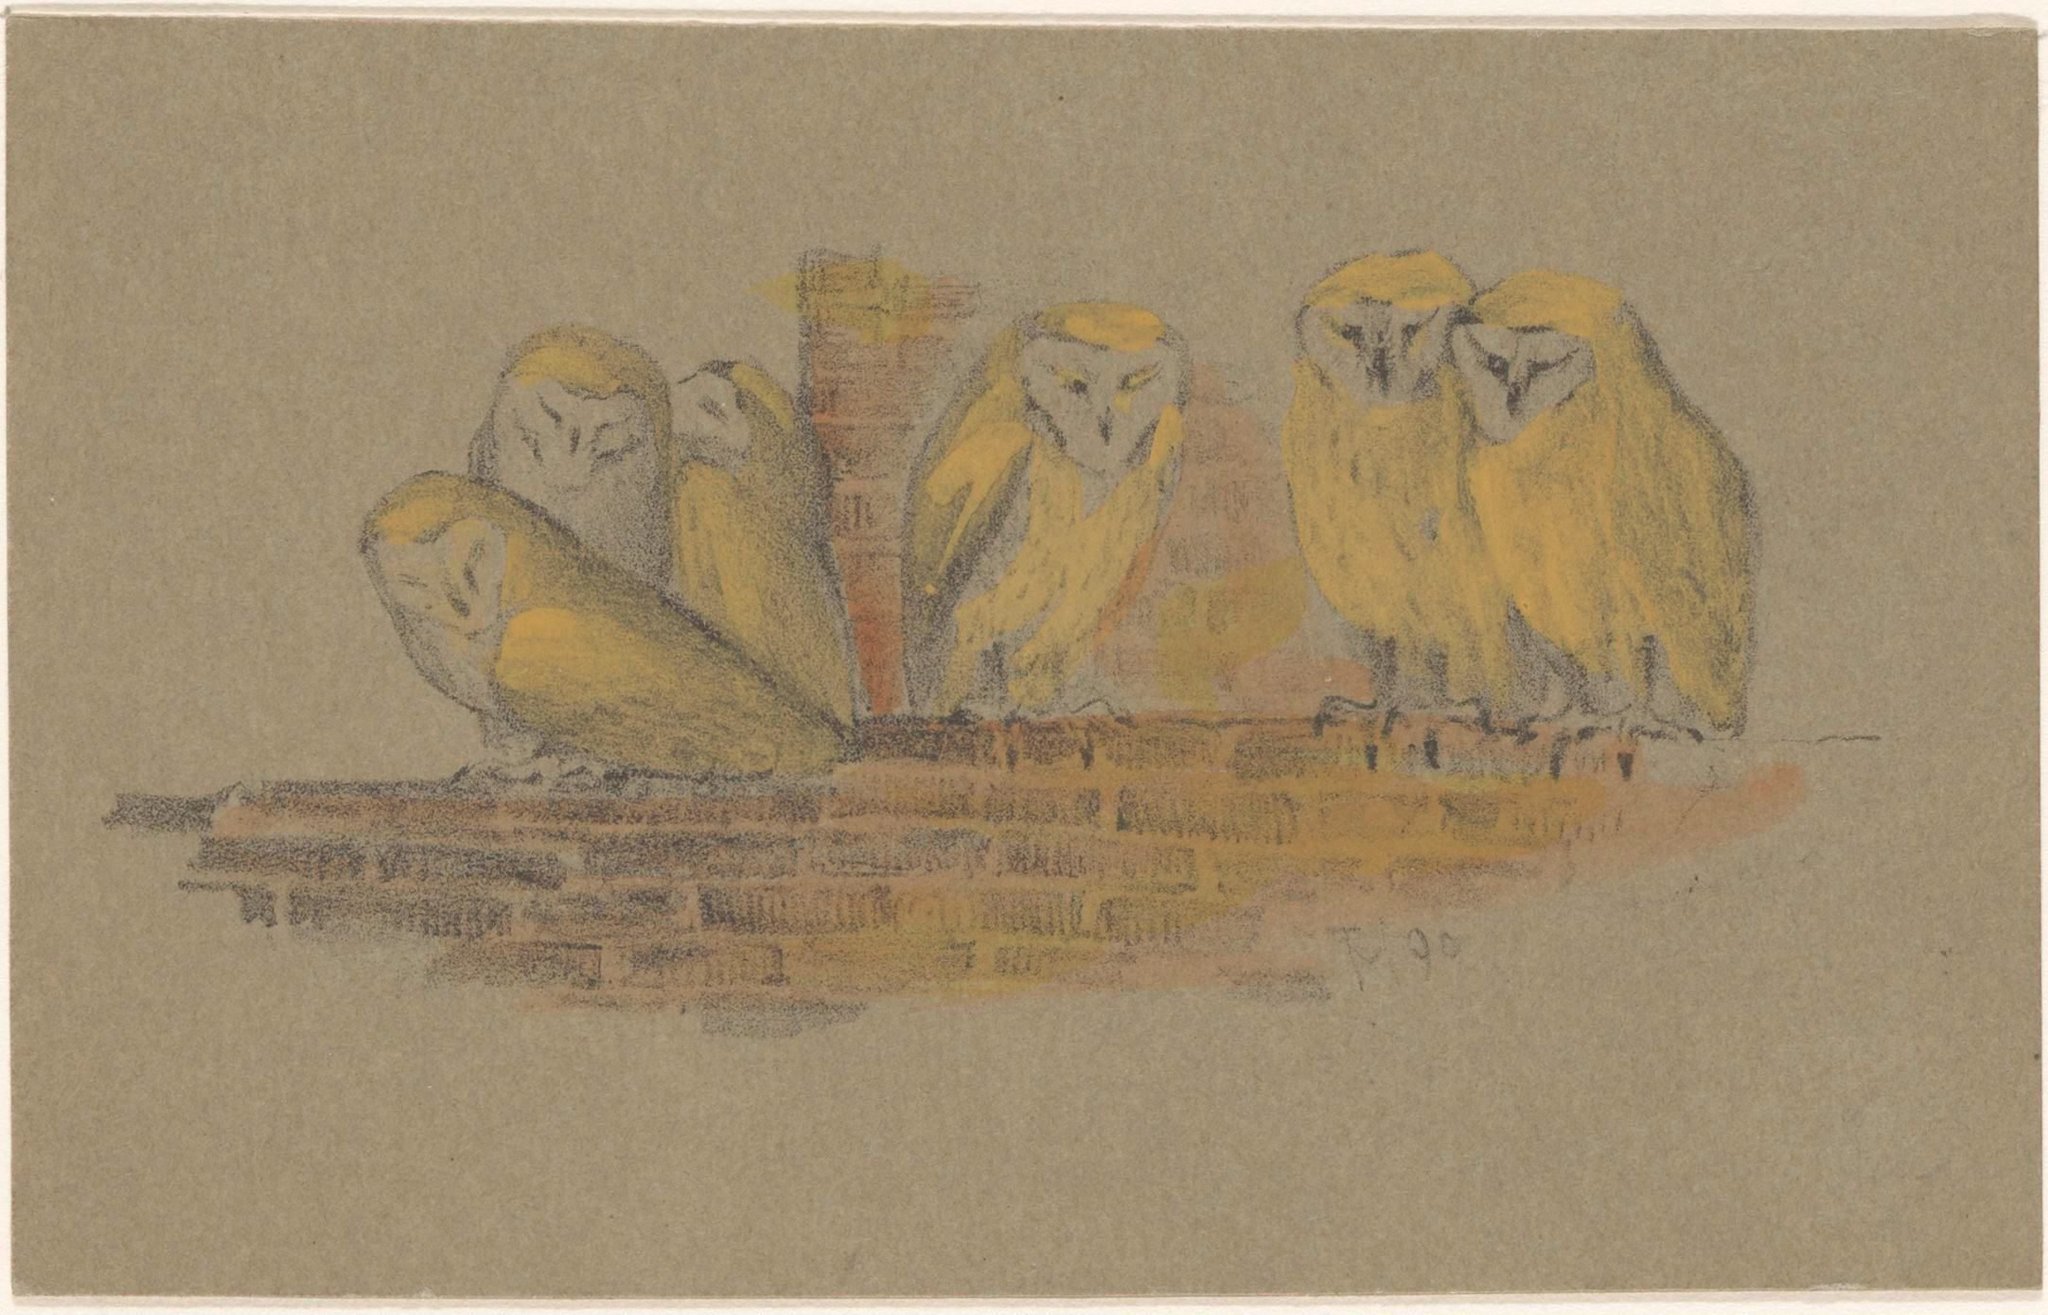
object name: greeting card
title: Wenskaart met zes uilen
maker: theo van hoytema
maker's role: draughtsman, painter, print maker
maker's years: 1863-1917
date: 1890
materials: paper, watercolor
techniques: hand coloring, lithograph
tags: owls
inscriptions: collector's mark: Lugt 2228